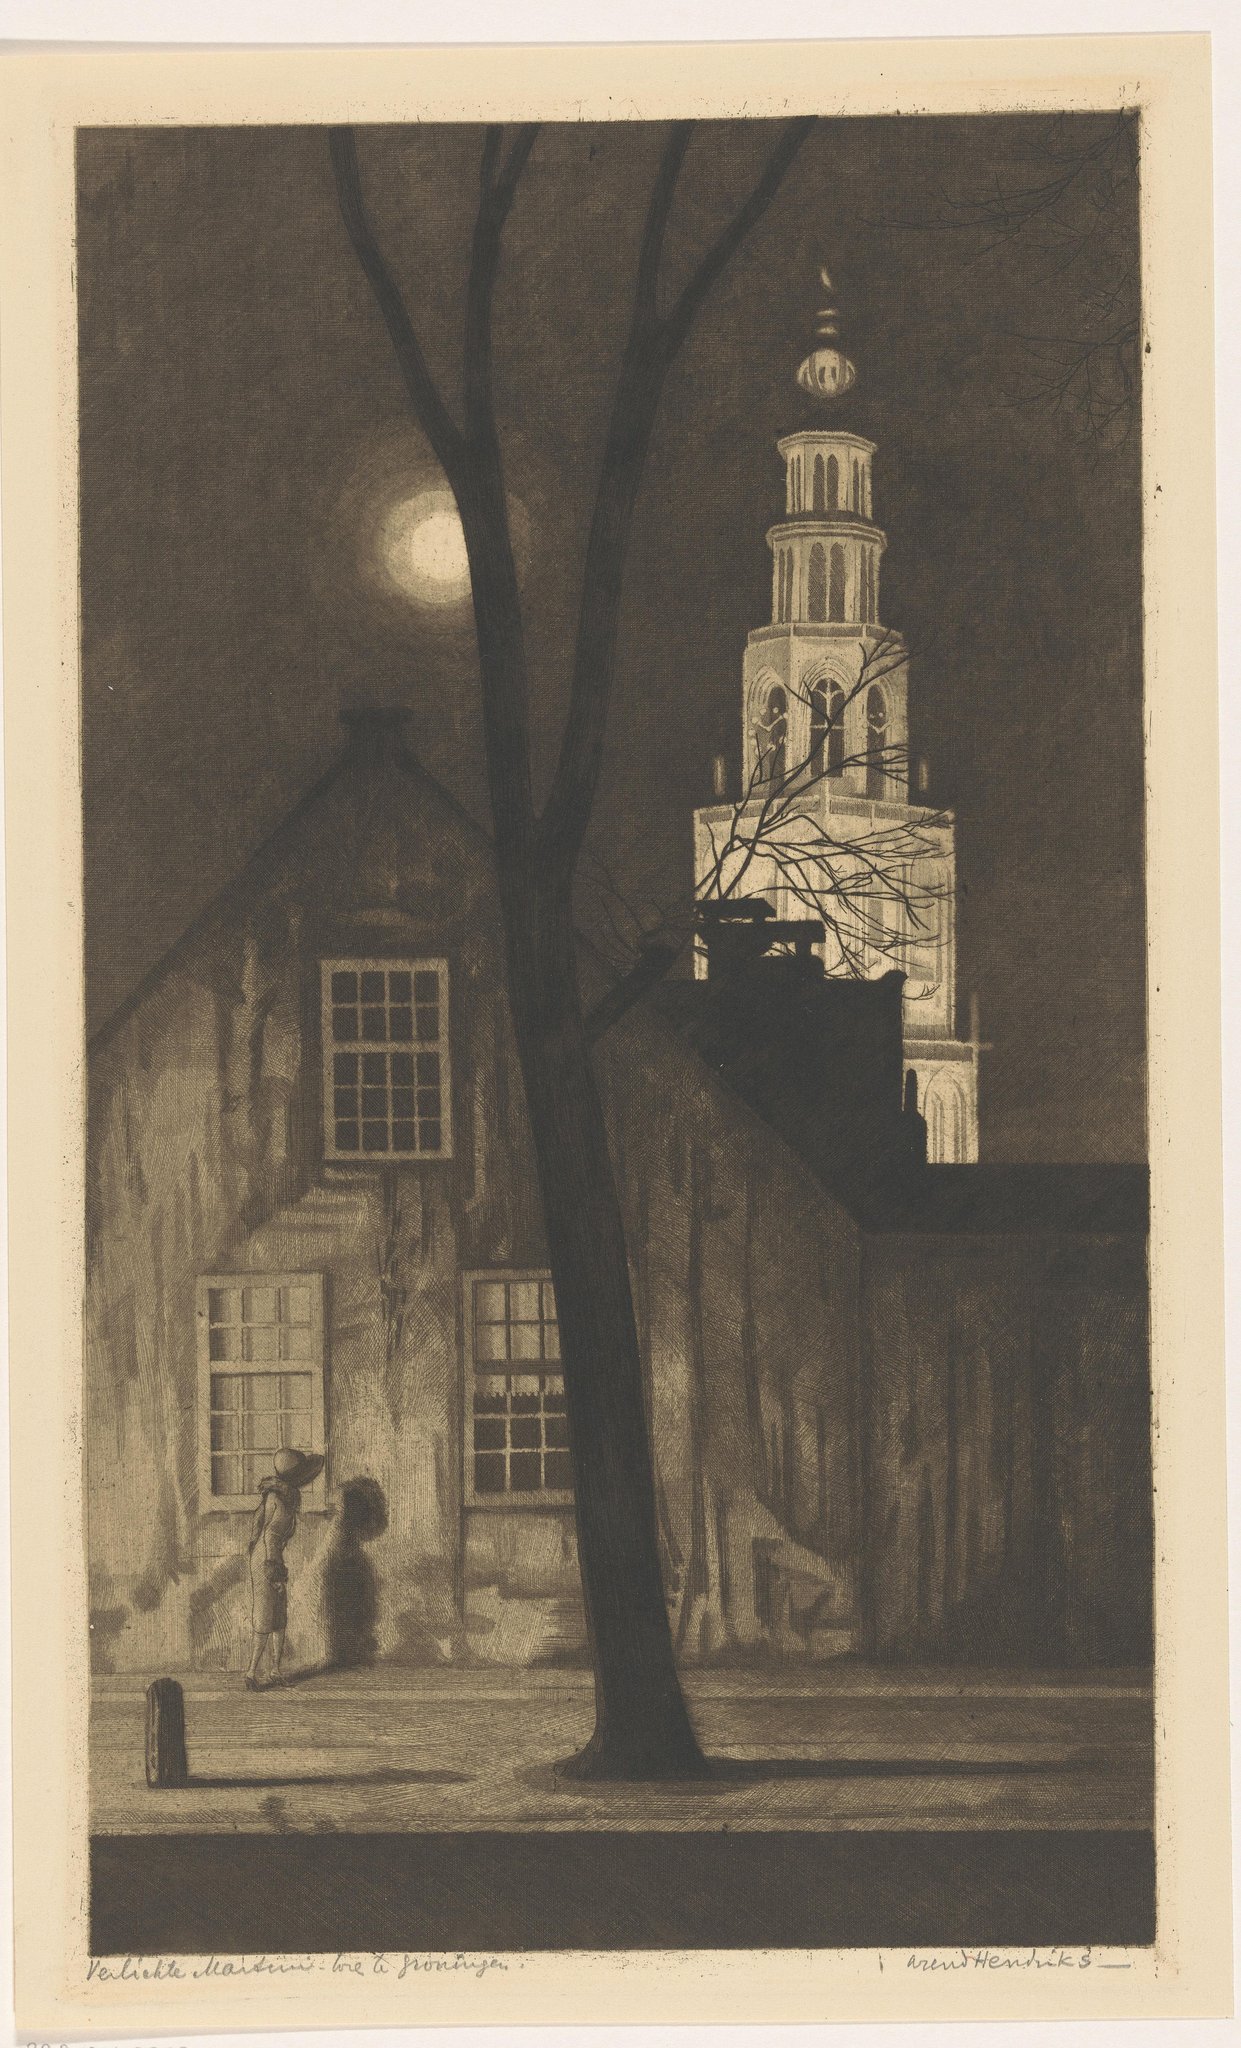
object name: print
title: Verlichte Martinitoren te Groningen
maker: arend hendriks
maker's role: print maker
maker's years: 1901-1951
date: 1911-1931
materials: paper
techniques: etching, intaglio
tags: full moon, parts of church exterior and annexes: tower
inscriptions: collector's mark: Lugt 2228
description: Een vrouw met bontjas en hoed staat voor een huis waarachter de verlichte Martinitoren te zien is.